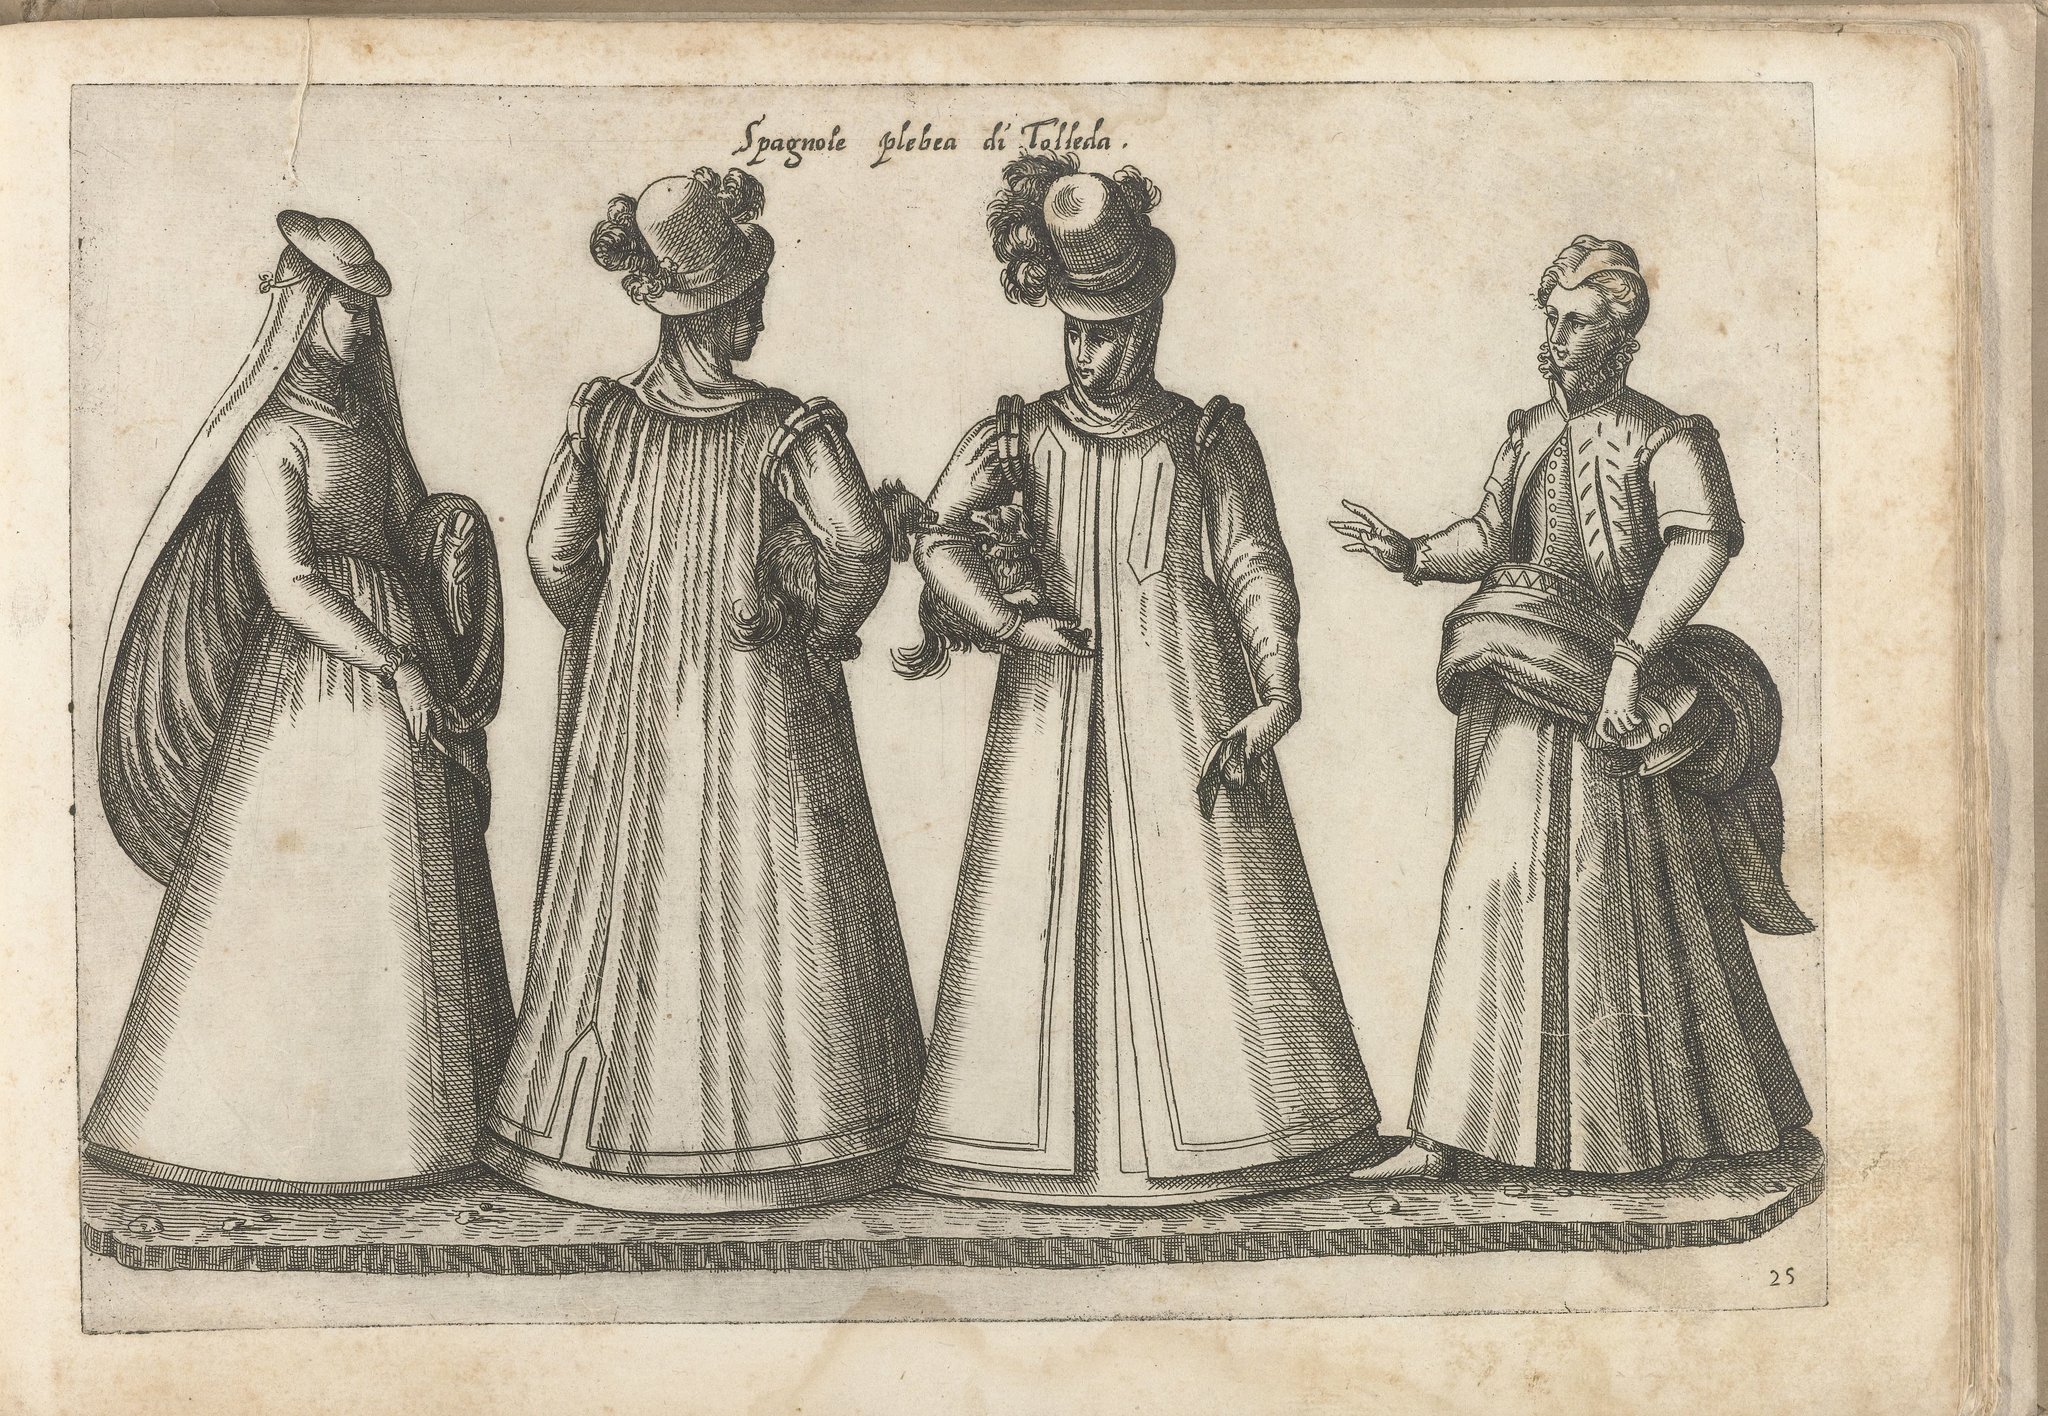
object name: costume print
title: Spagnole plebea di Tolleda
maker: bartolomeo grassi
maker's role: publisher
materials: paper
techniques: engraving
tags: europeans: spaniards, head-gear: hat (+ women's clothes), dress, gown (+ women's clothes), dog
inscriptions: number: ‘24’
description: De twee middelste vrouwen hebben ieder een hondje onder de arm. Prent nr. 25 uit album 'Dei veri ritratti degl'habiti di tvtte le parti del mondo intagliati in rame per opra di Bartolomeo Grassi', 1585.